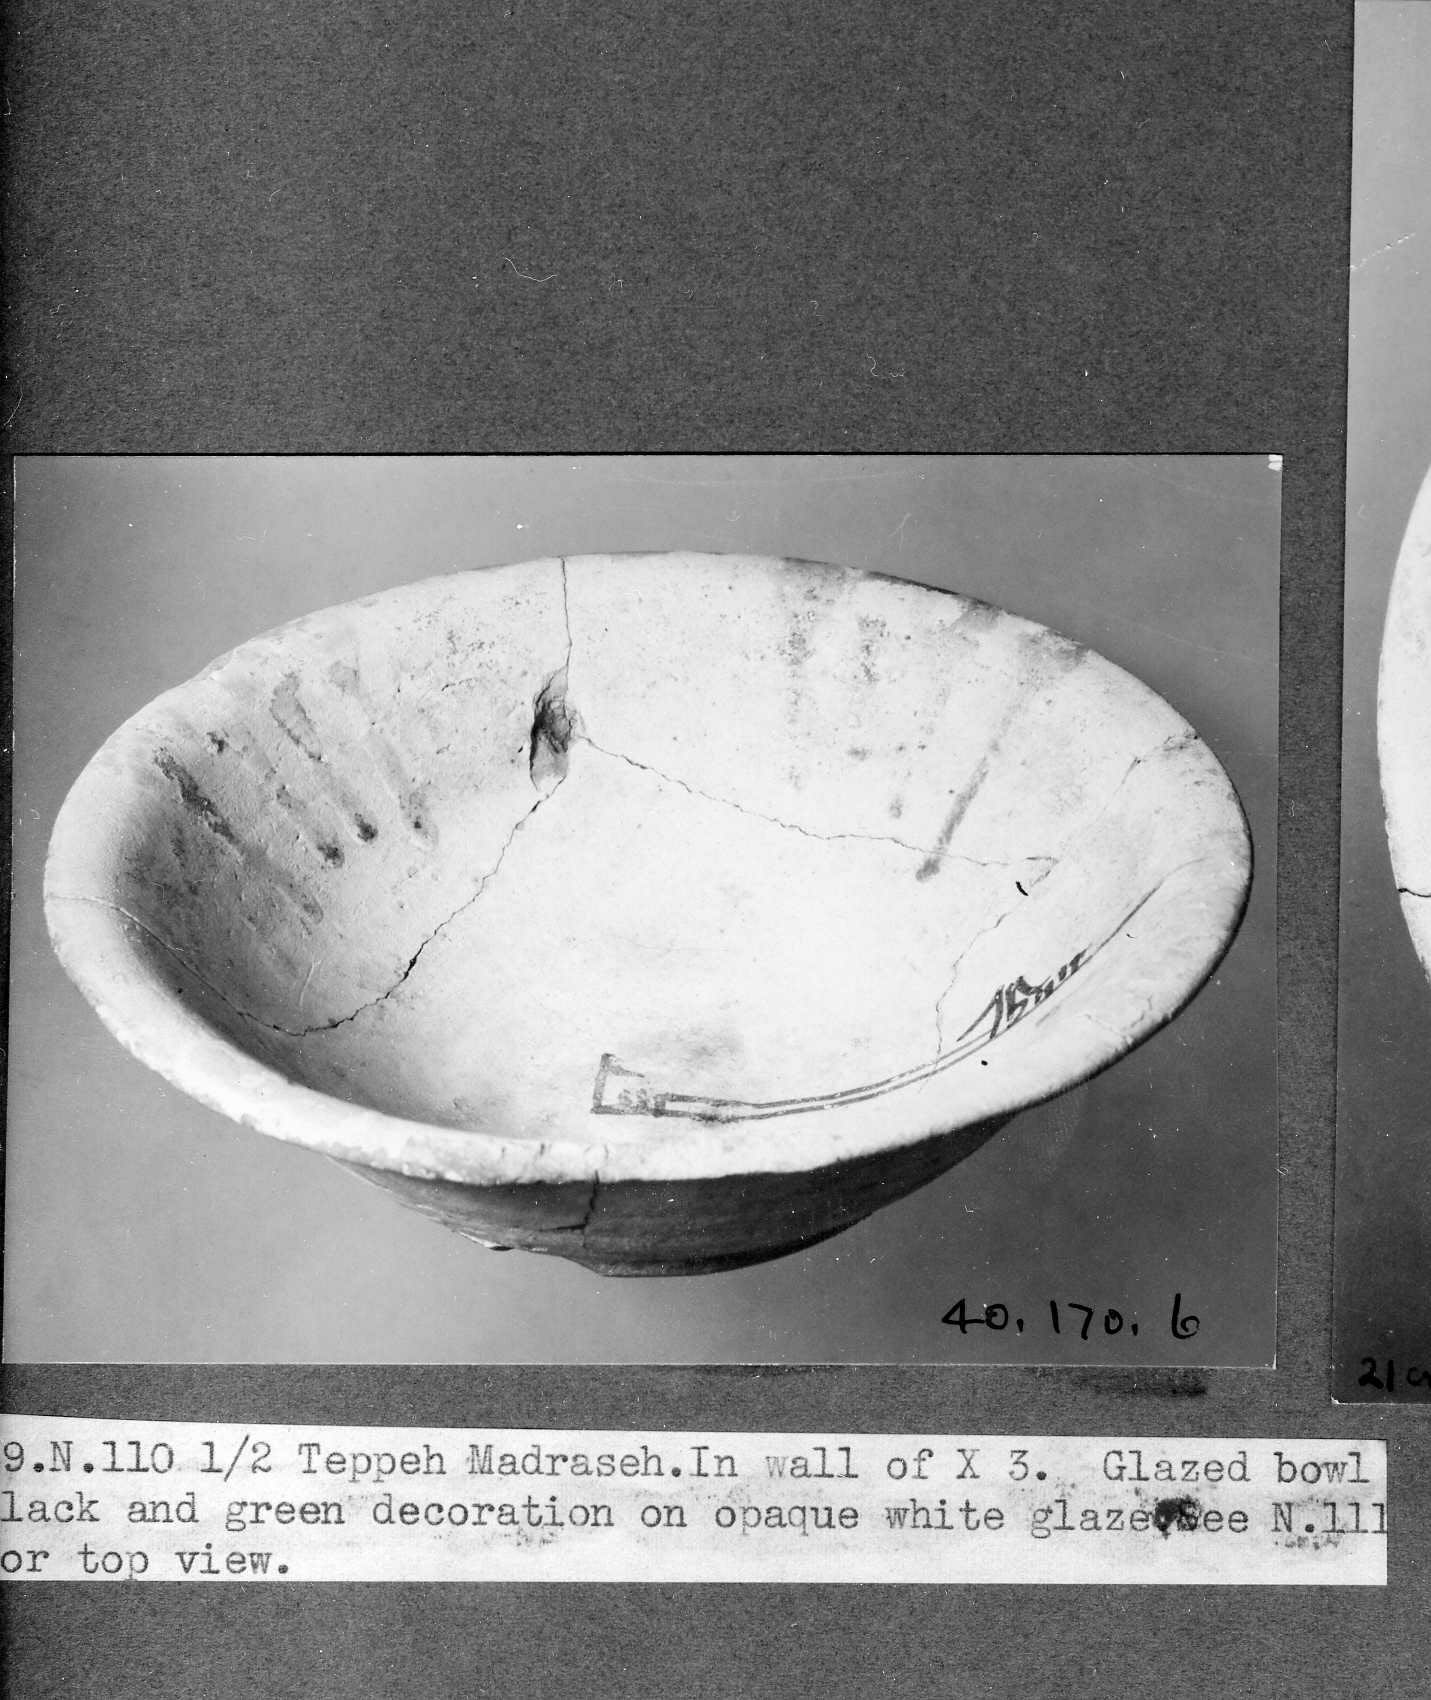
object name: bowl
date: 701-900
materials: earthenware, glaze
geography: iran